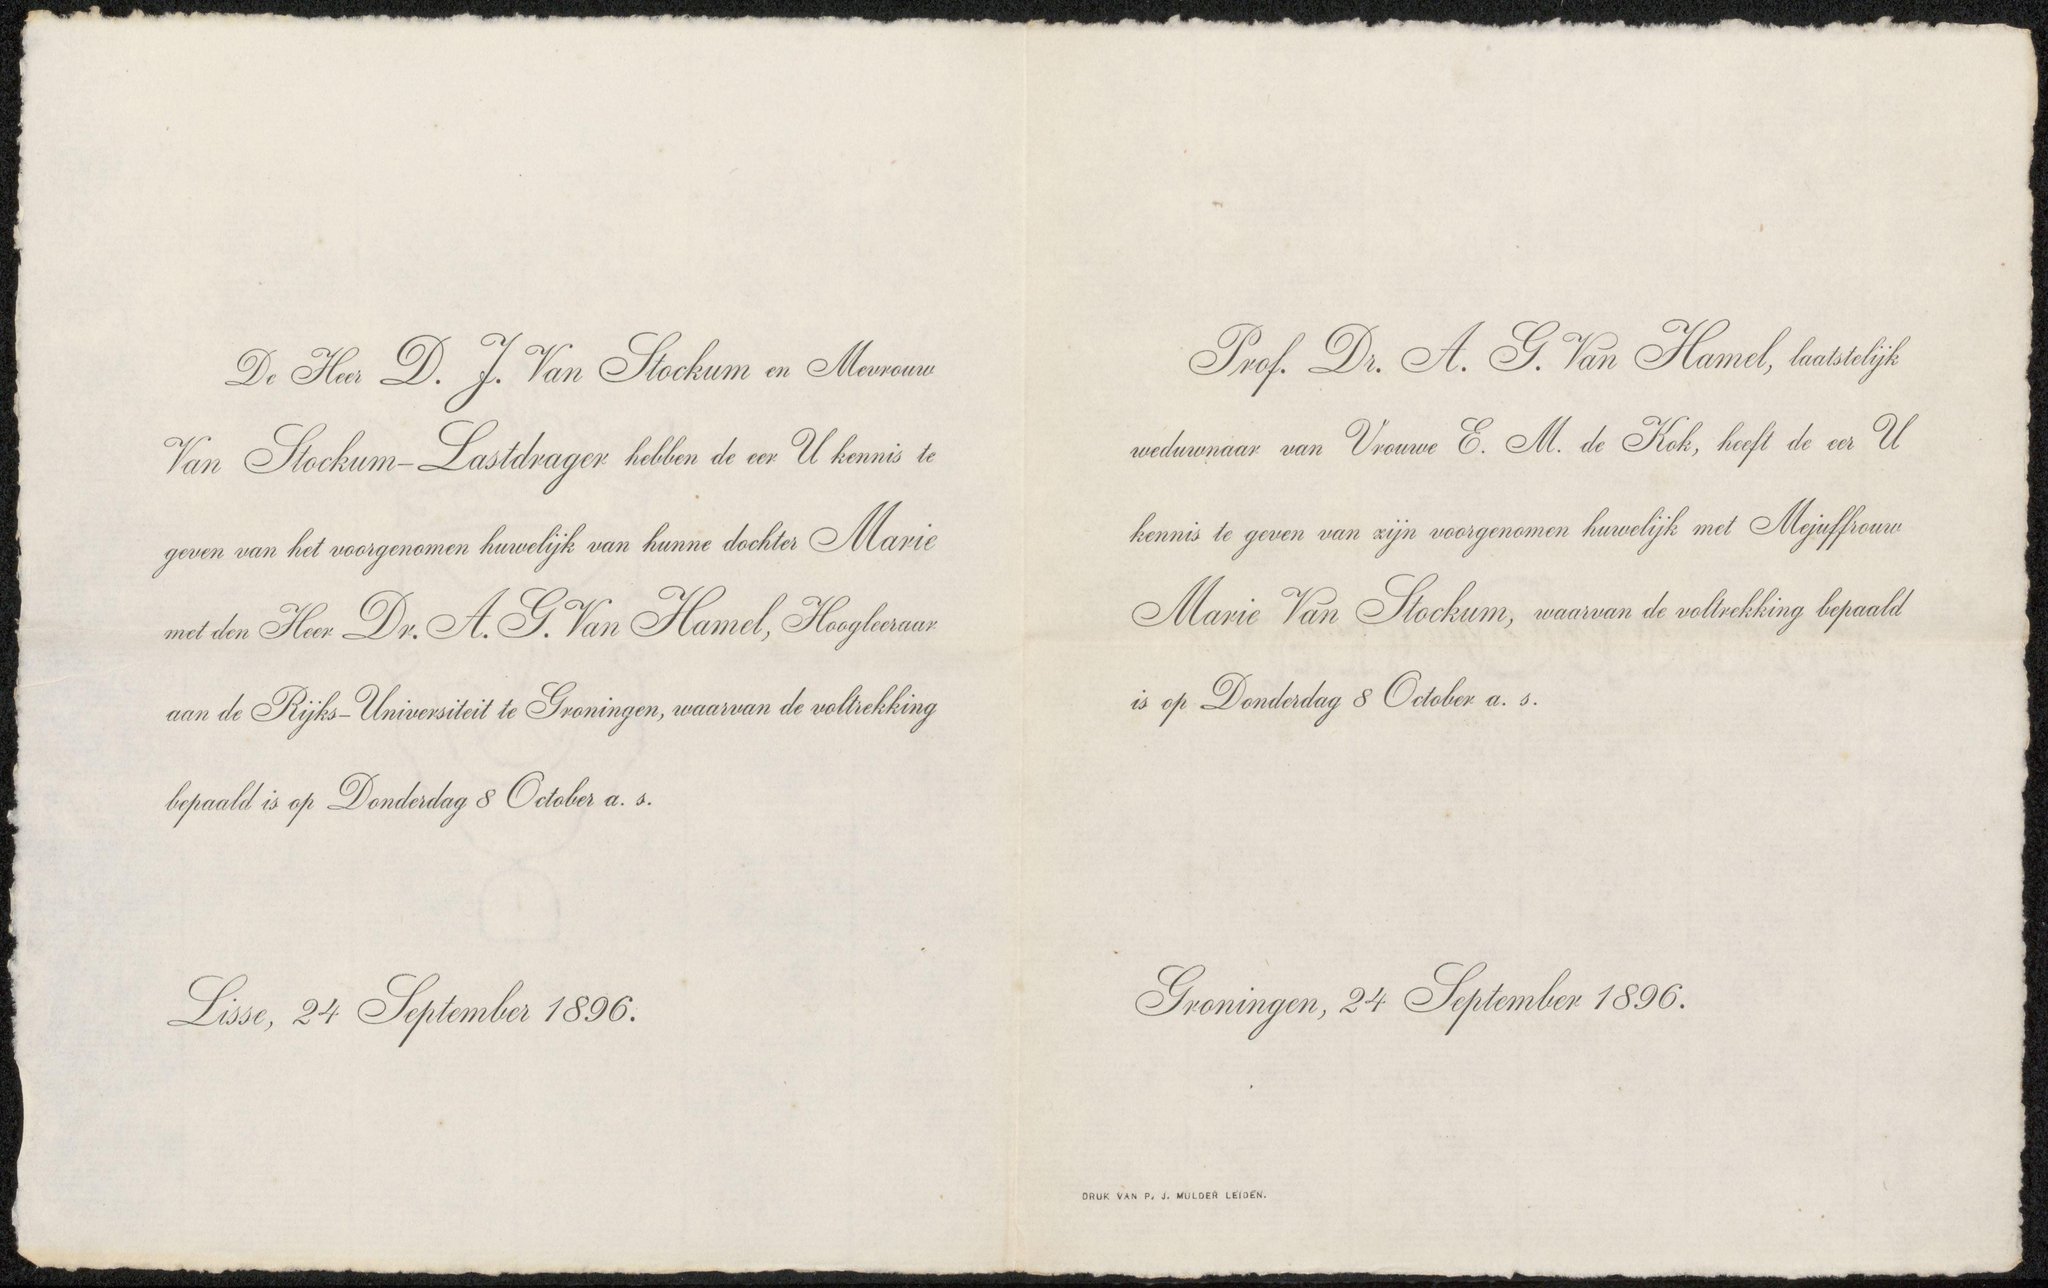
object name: wedding announcement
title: Huwelijksaankondiging aan Philip Zilcken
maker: pieter jacobus mulder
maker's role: draughtsman, print maker, printer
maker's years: 1836-1923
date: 1896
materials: paper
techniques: printing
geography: leiden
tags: haarlem, antonius gerardus van hamel, the hague, philip zilcken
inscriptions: collector's mark: ‘RPK’